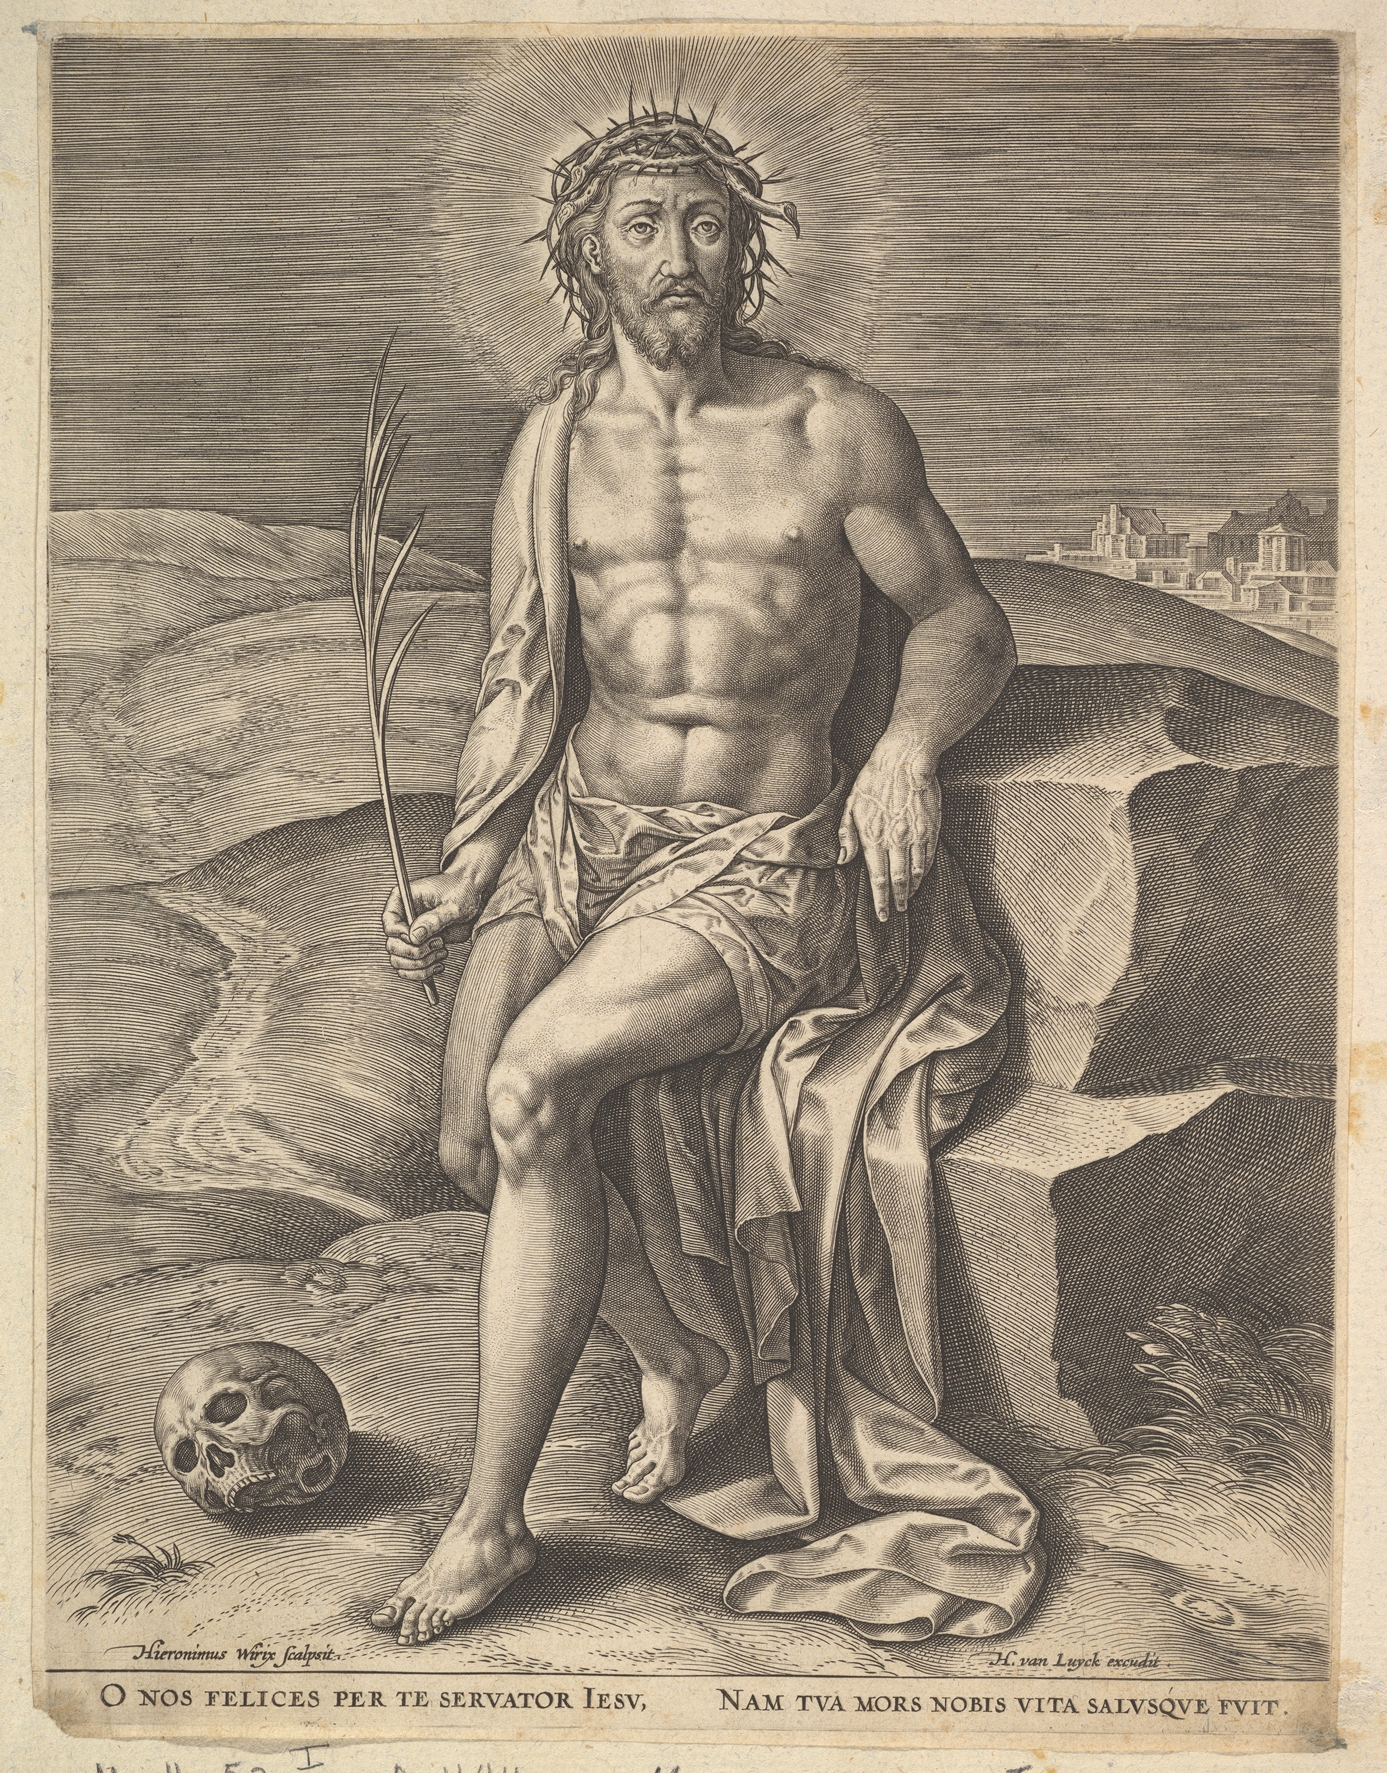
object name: print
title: Christ Sitting on the Cold Stone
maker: hieronymus wierix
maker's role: artist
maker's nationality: netherlandish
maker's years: 1553-1619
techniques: engraving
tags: skulls,christ